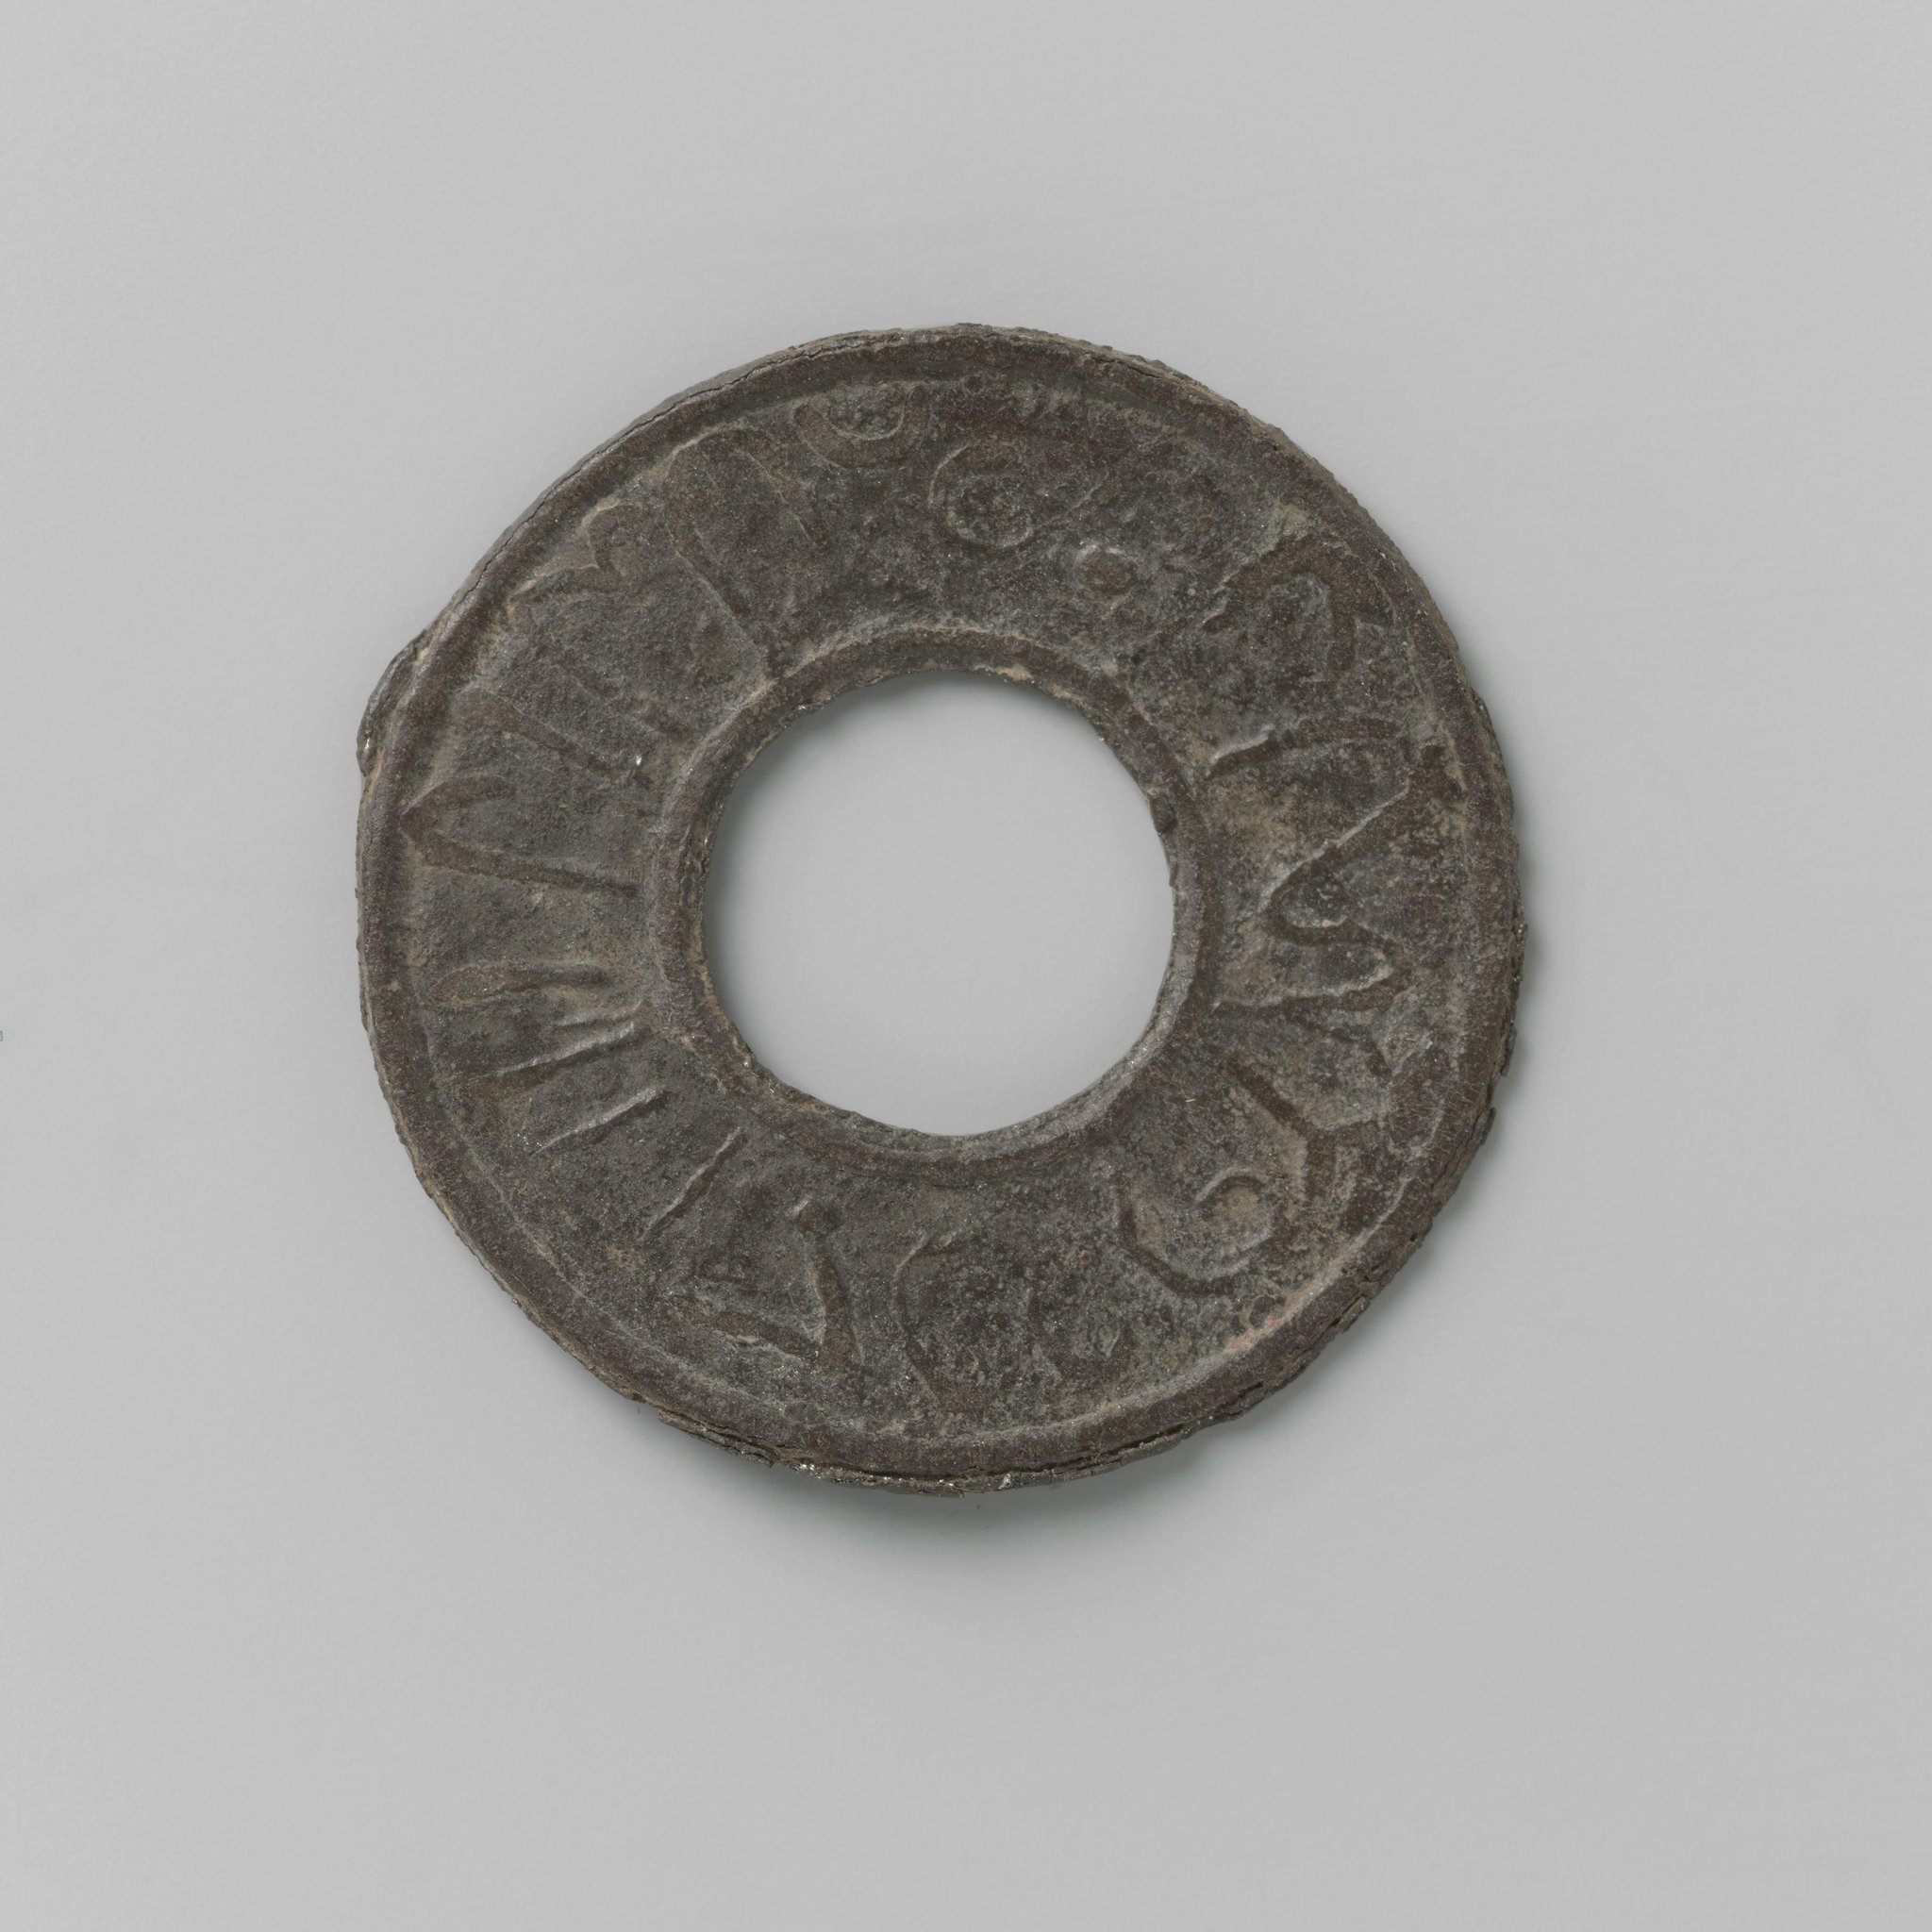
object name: coin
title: Djokjakarta, Java, pitji of keteng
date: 1700-1800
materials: lead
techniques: casting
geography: soerakarta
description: Loden munt. Voorzijde: Omschrift in Javaanse lettertekens. Keerzijde: glad. In het midden rond gat.